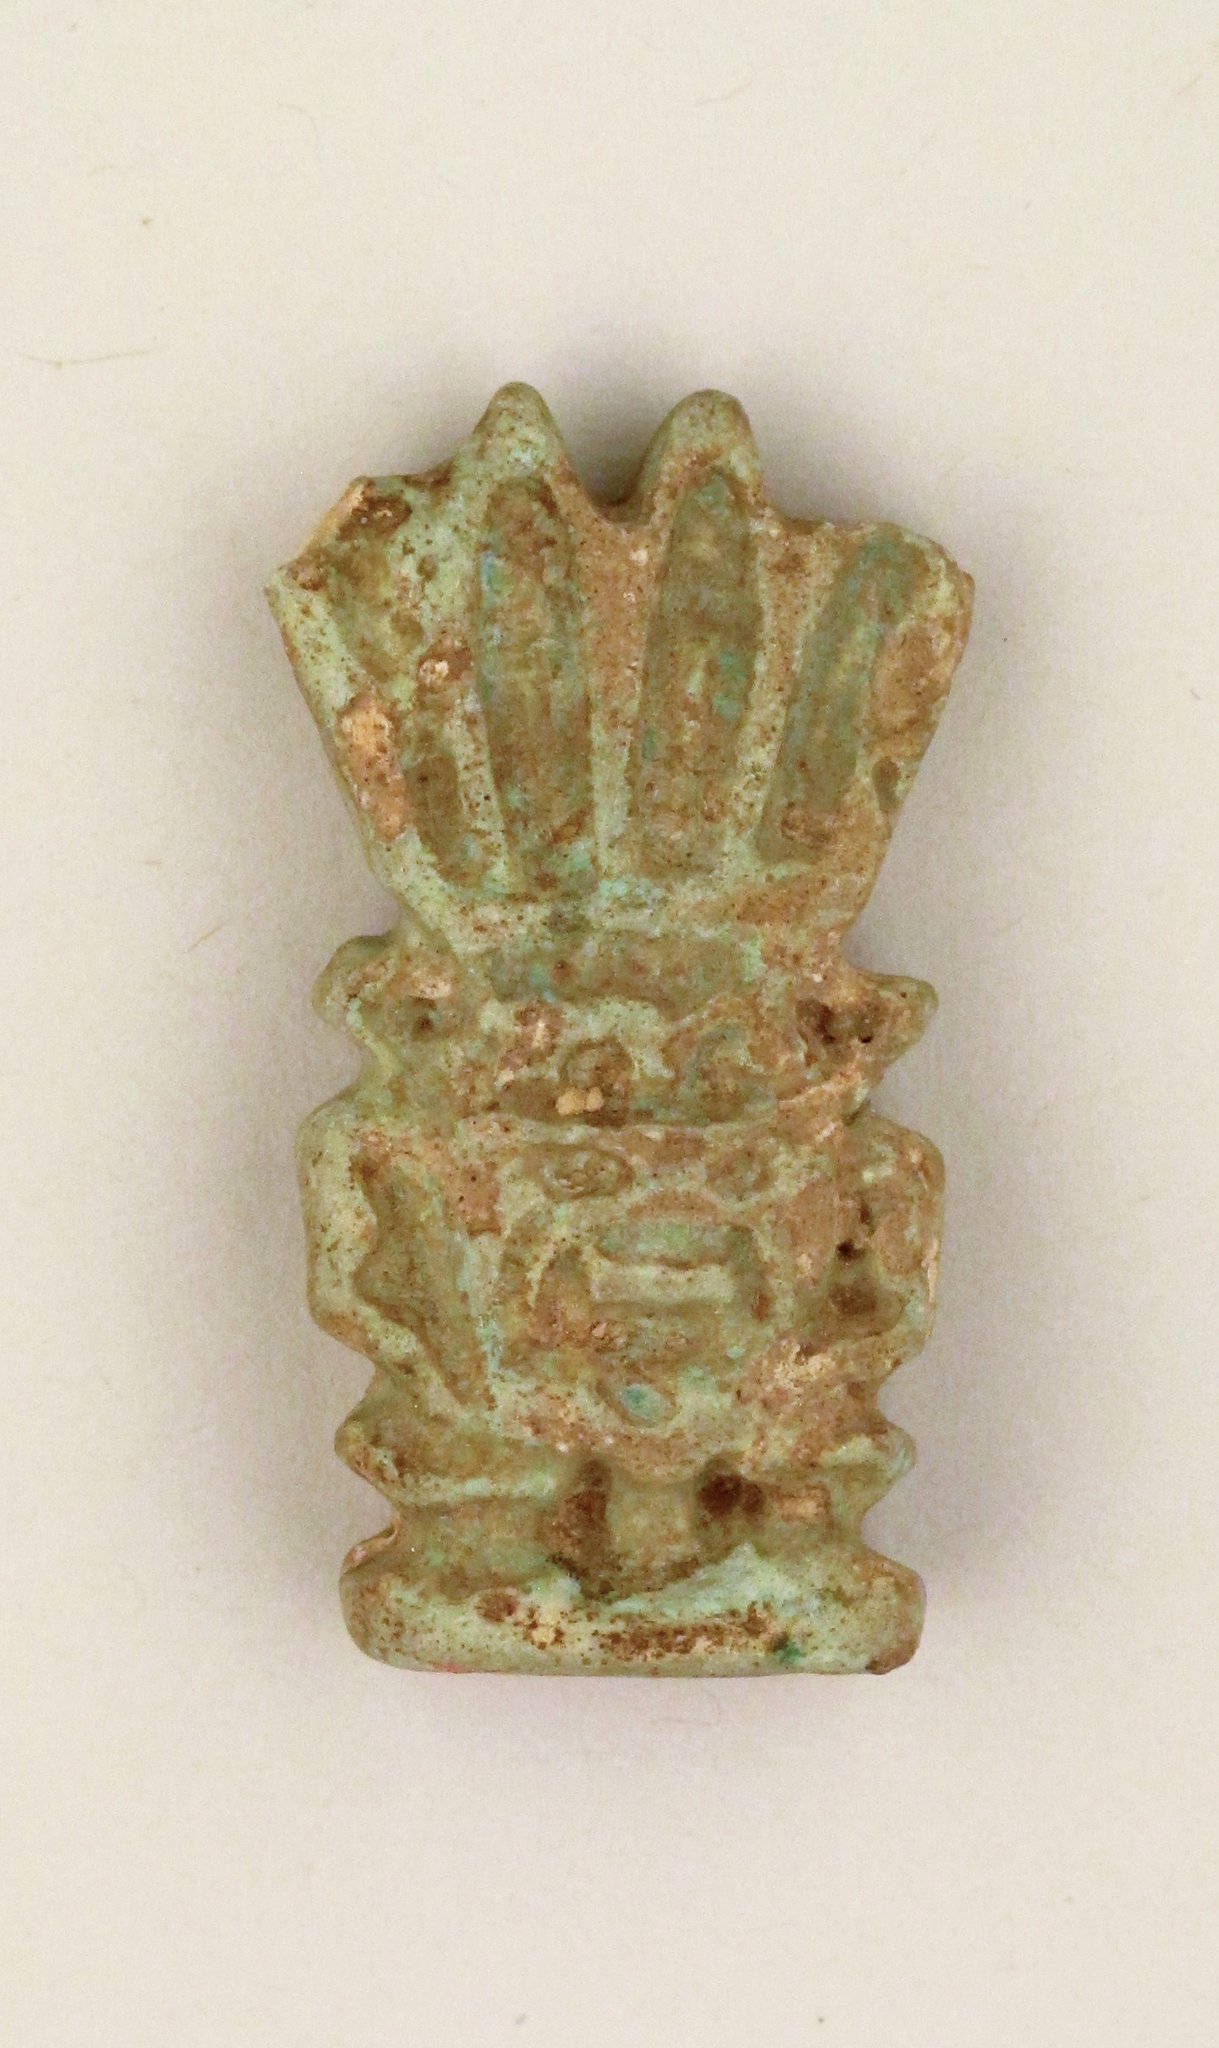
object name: amulet, be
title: Faience amulet of Bes image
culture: egyptian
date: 1090-900 BCE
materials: faience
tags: bes